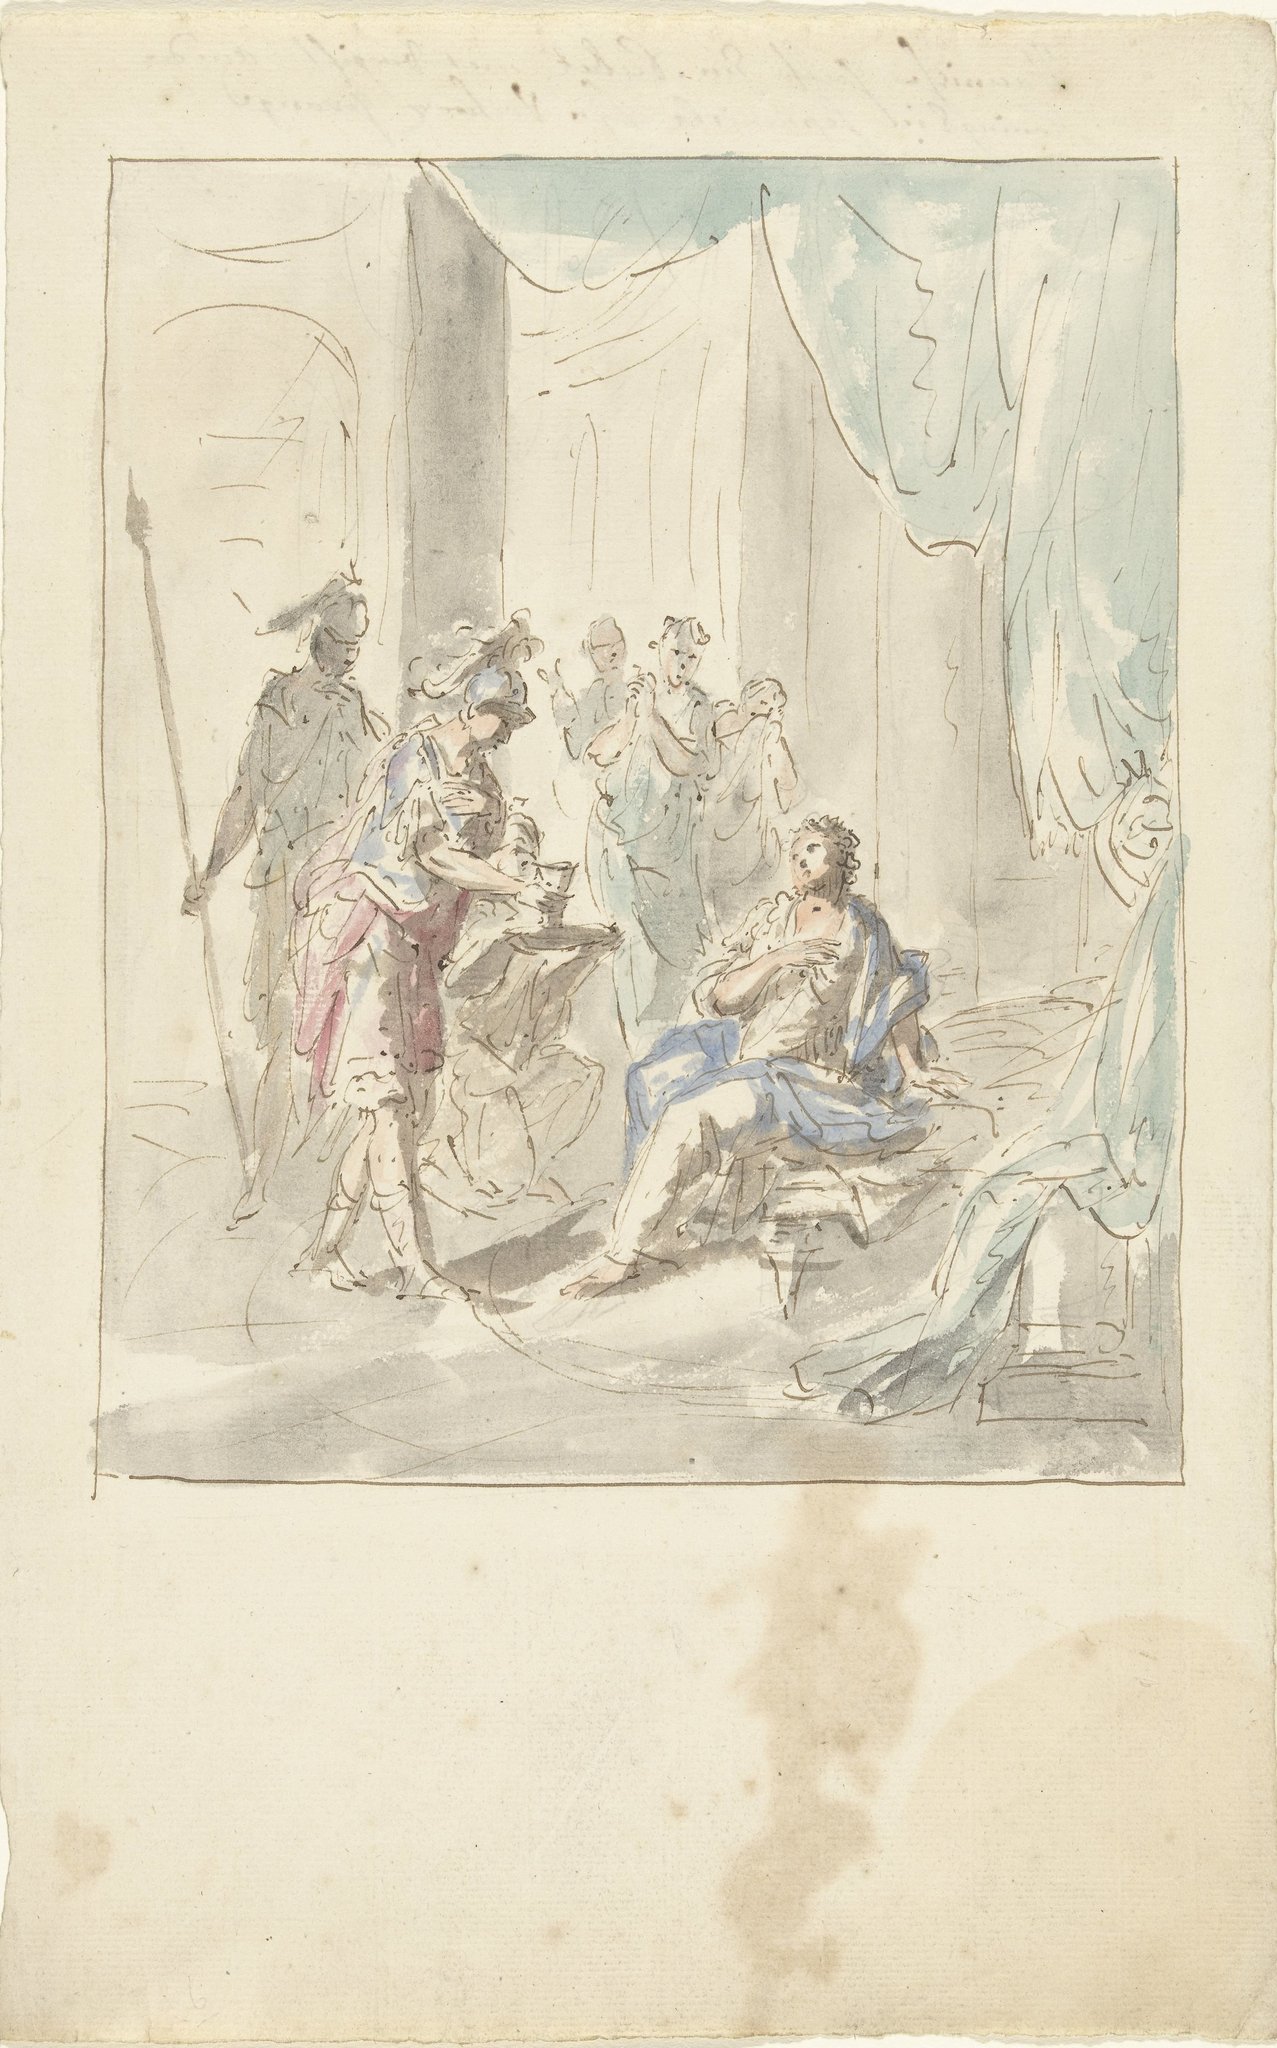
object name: drawing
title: Masinissa reikt Sophonisbe de gifbeker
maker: elias van nijmegen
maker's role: draughtsman, painter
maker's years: 1667-1755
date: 1677-1755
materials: ink, paper, pencil, watercolor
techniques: brush, pen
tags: death of sophonisbe: she receives from a servant a cup of poison sent to her by masinissa